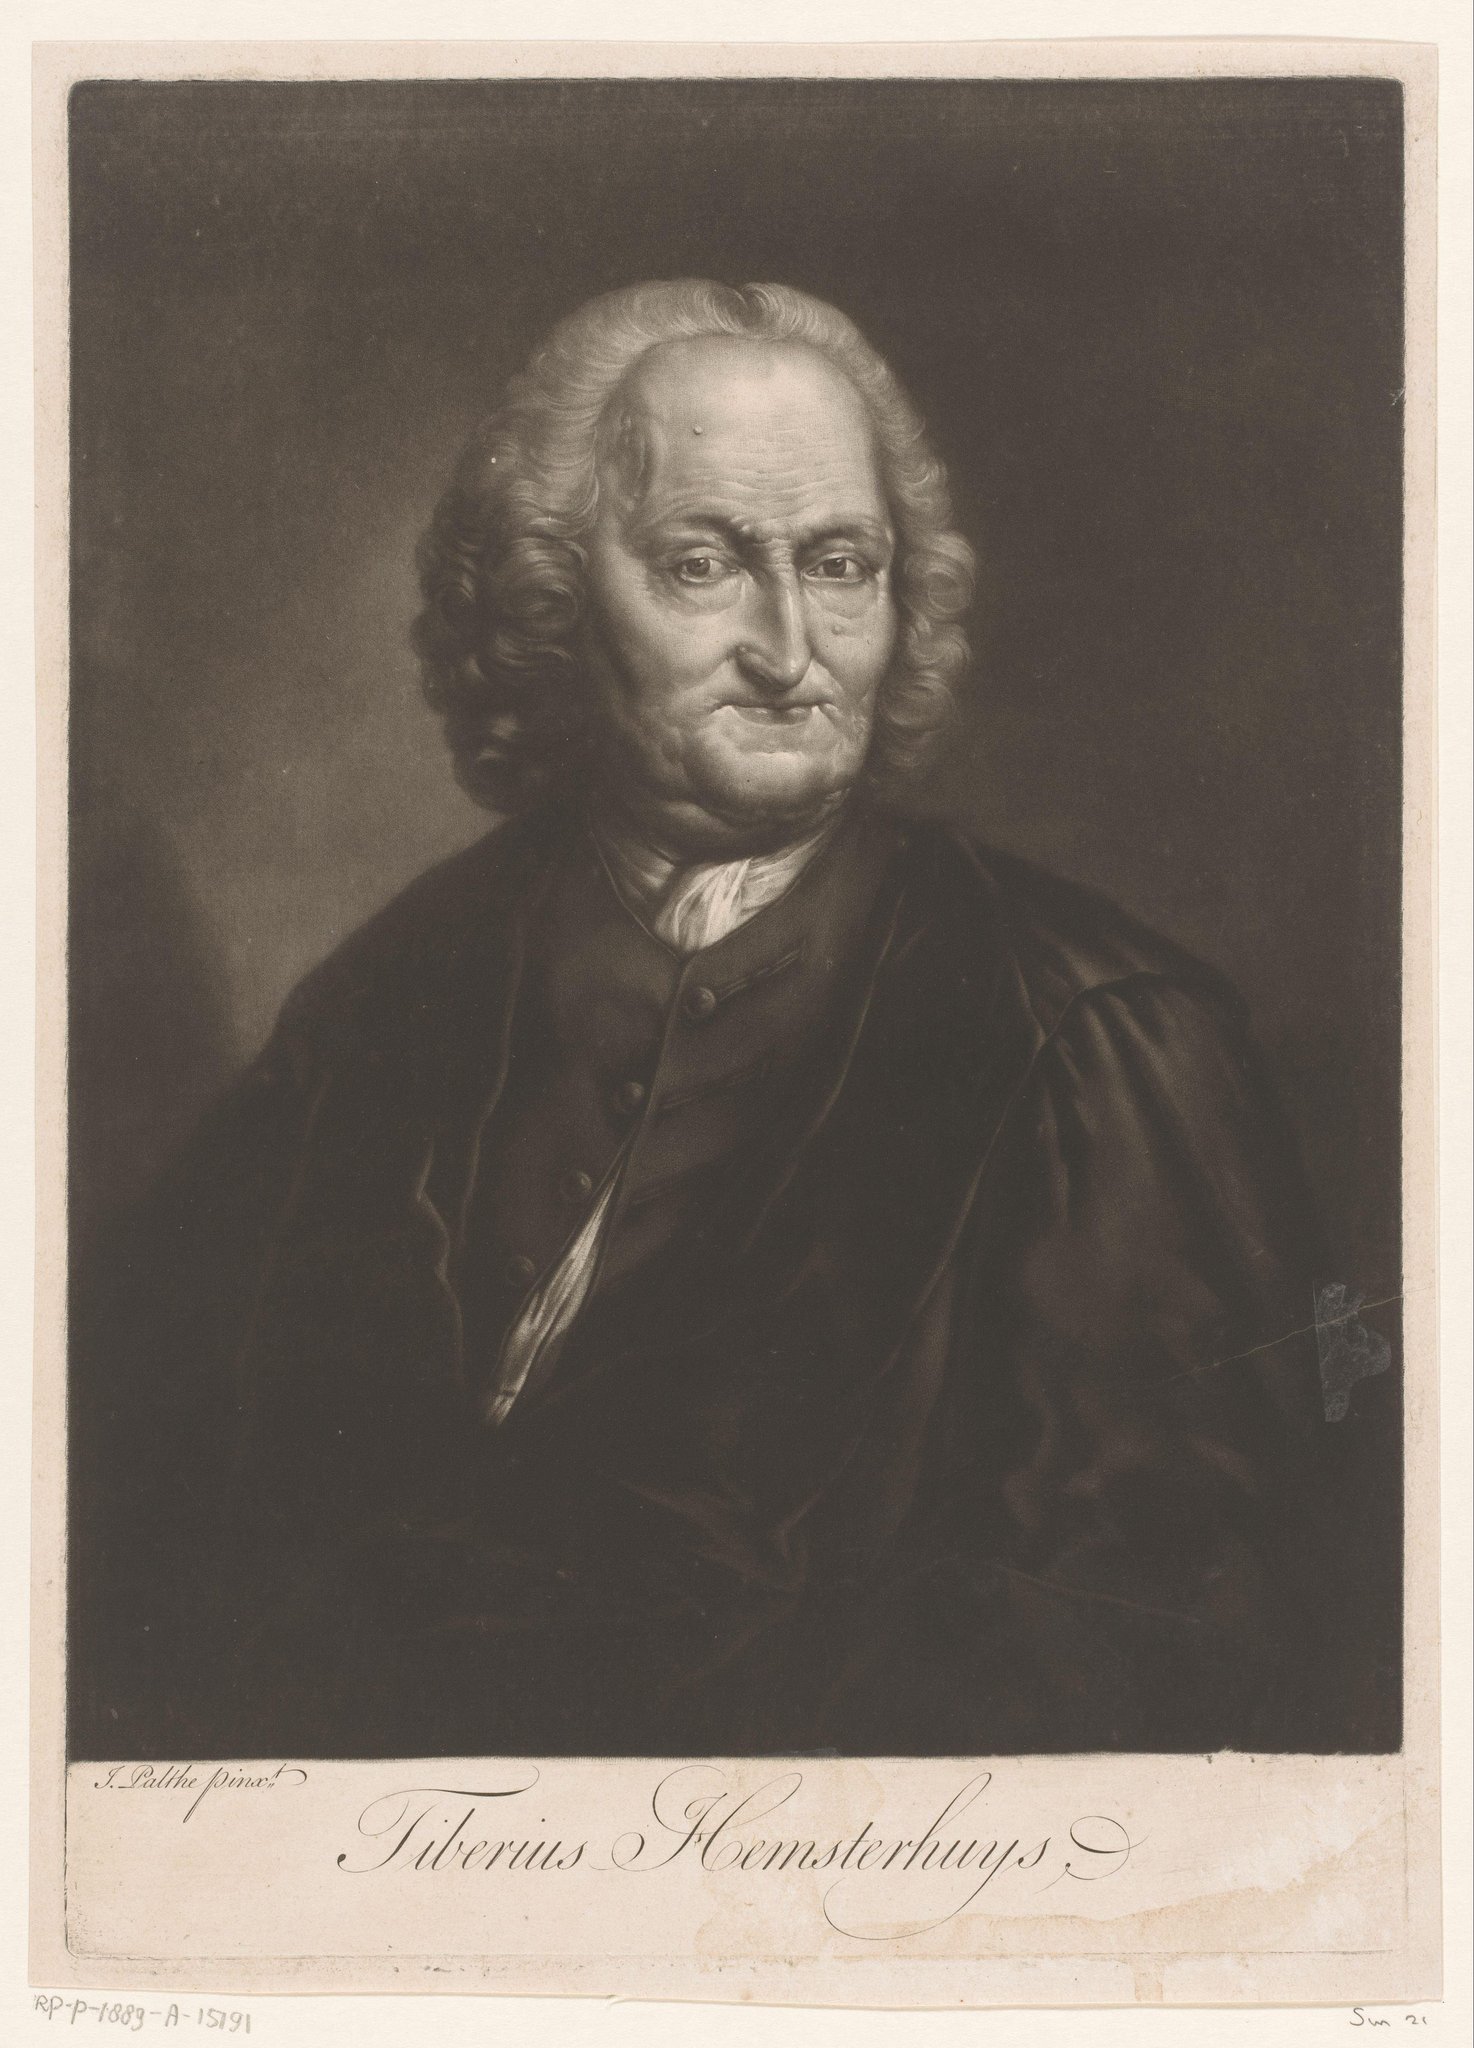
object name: print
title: Tiberius Hemsterhuys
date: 1741-1800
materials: paper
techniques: mezzotint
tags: leiden, historical persons, portrait of a writer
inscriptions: collector's mark: Lugt 2228